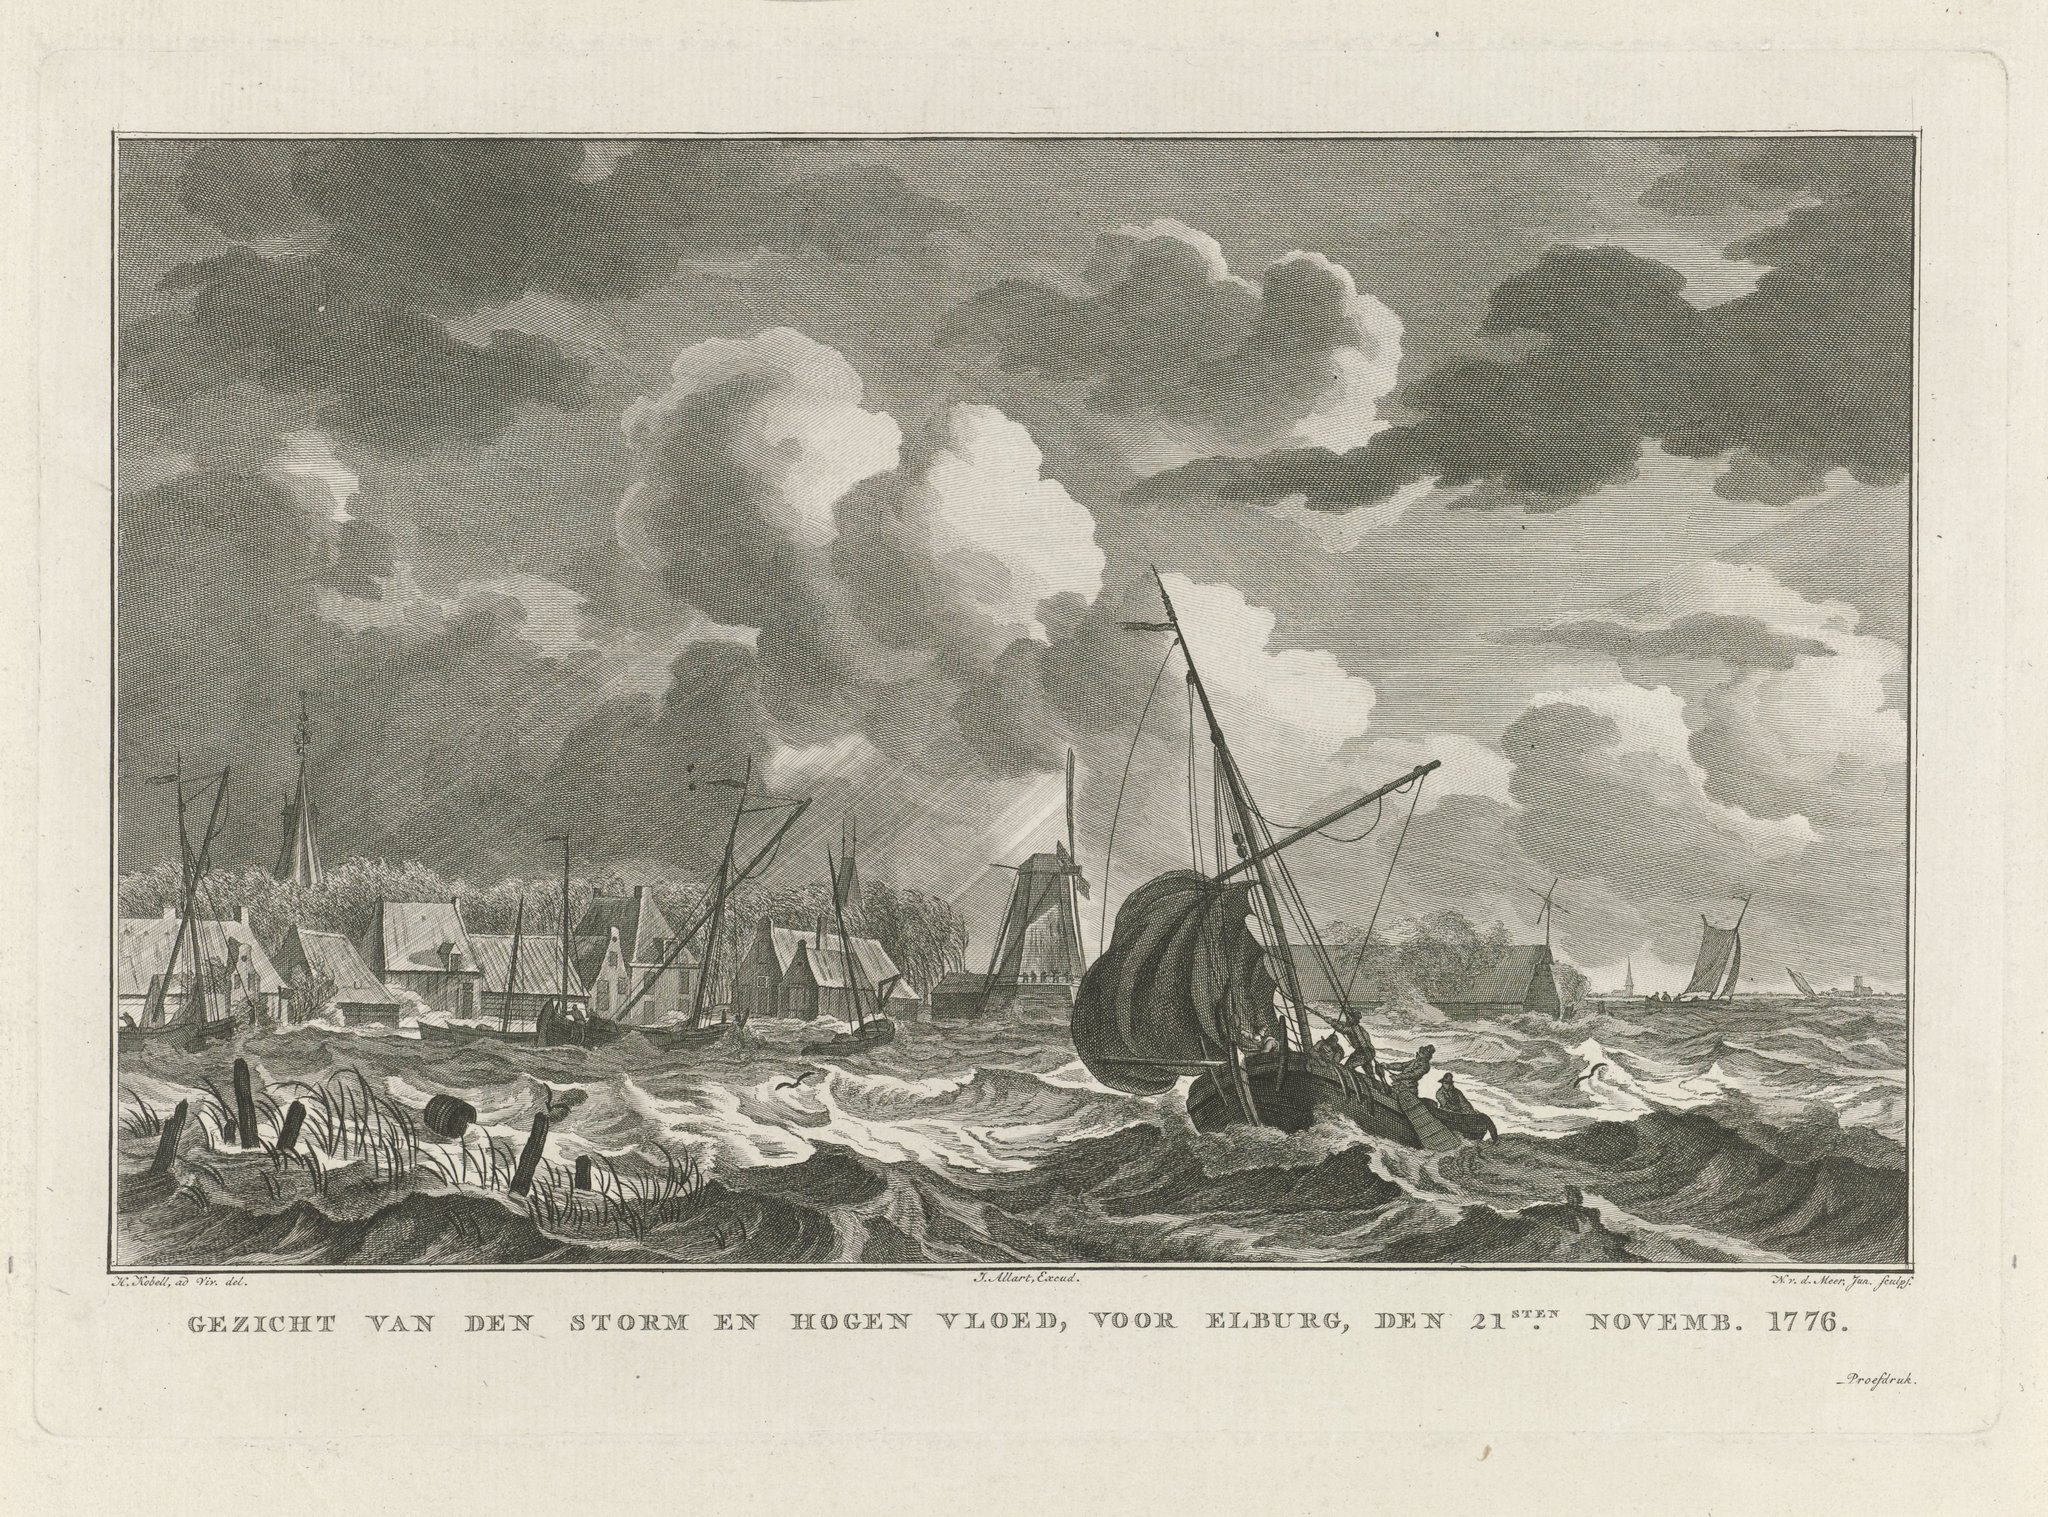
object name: book illustration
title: Storm en hoge vloed bij Elburg, 1776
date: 1778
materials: paper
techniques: engraving, etching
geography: amsterdam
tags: sailing-ship, sailing-boat, flood, storm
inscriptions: collector's mark: Lugt 2228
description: Storm en hoge vloed bij het dorp Elburg op 21 november 1776. Op de voorgrond een schip in nood, waarvan de zeilen worden gehesen. De huizen staan in het water. Onderdeel van een groep illustraties van de watersnood in 1776.